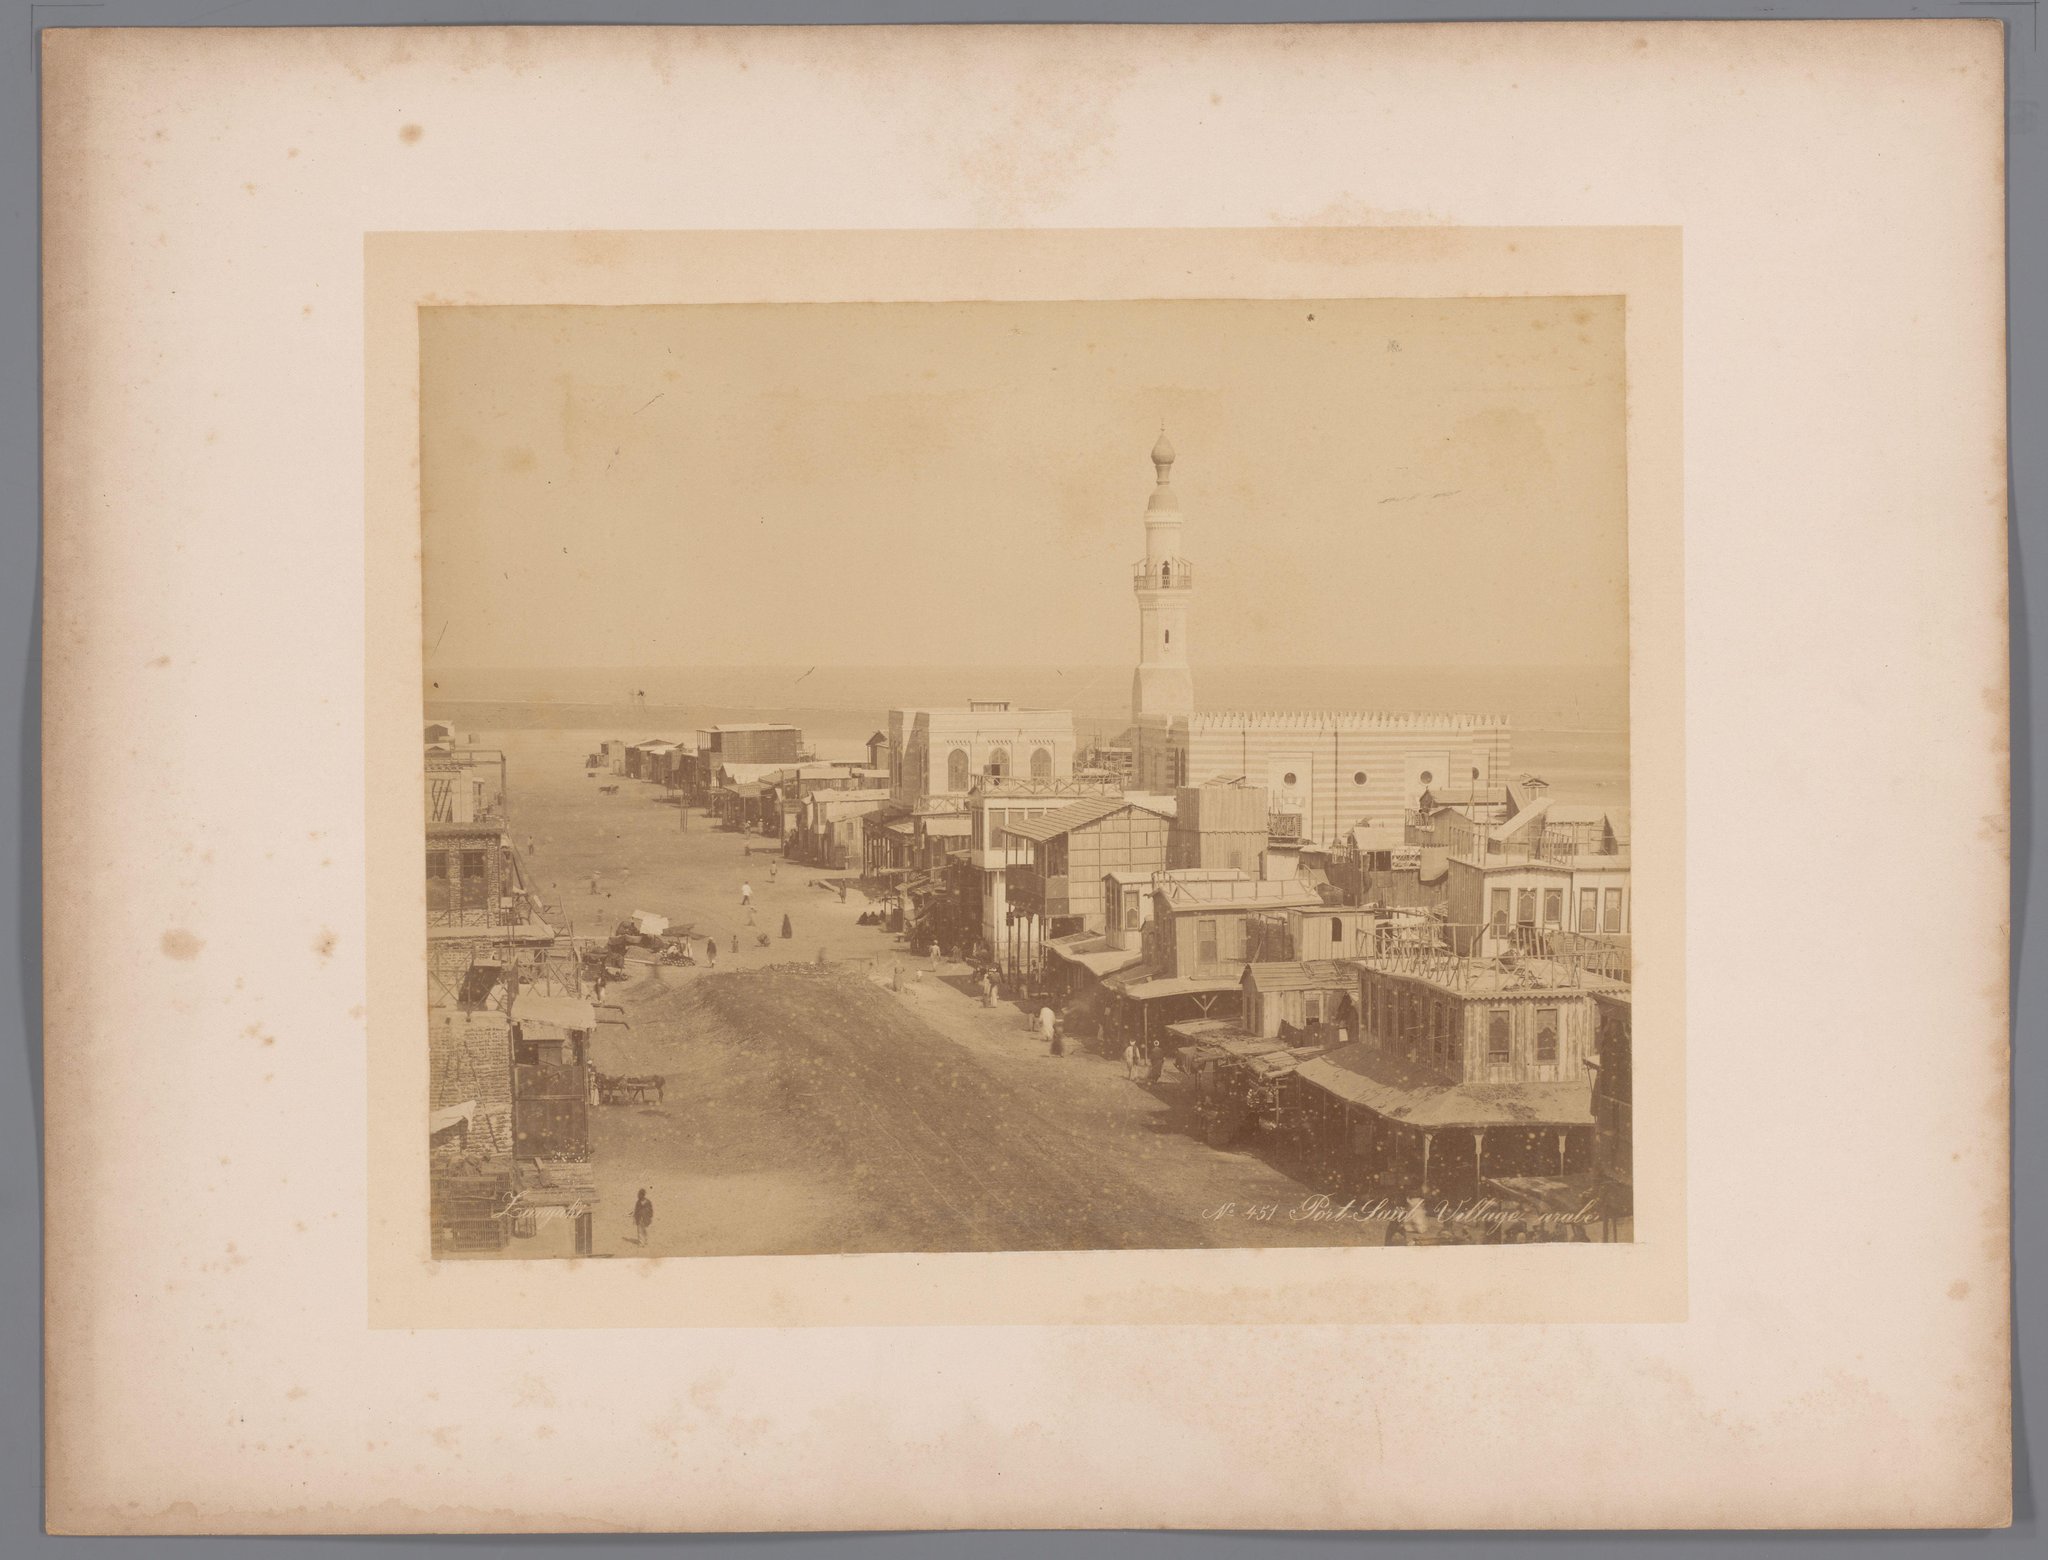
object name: photograph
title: Gezicht op Port Said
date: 1870-1910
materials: cardboard, paper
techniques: albumen print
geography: port said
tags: public road in village, temple, shrine ~ islam, mohammedanism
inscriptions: inscription: ‘foto Zangaki/ Port Said Arabisch dorp’, number: ‘No. 451’